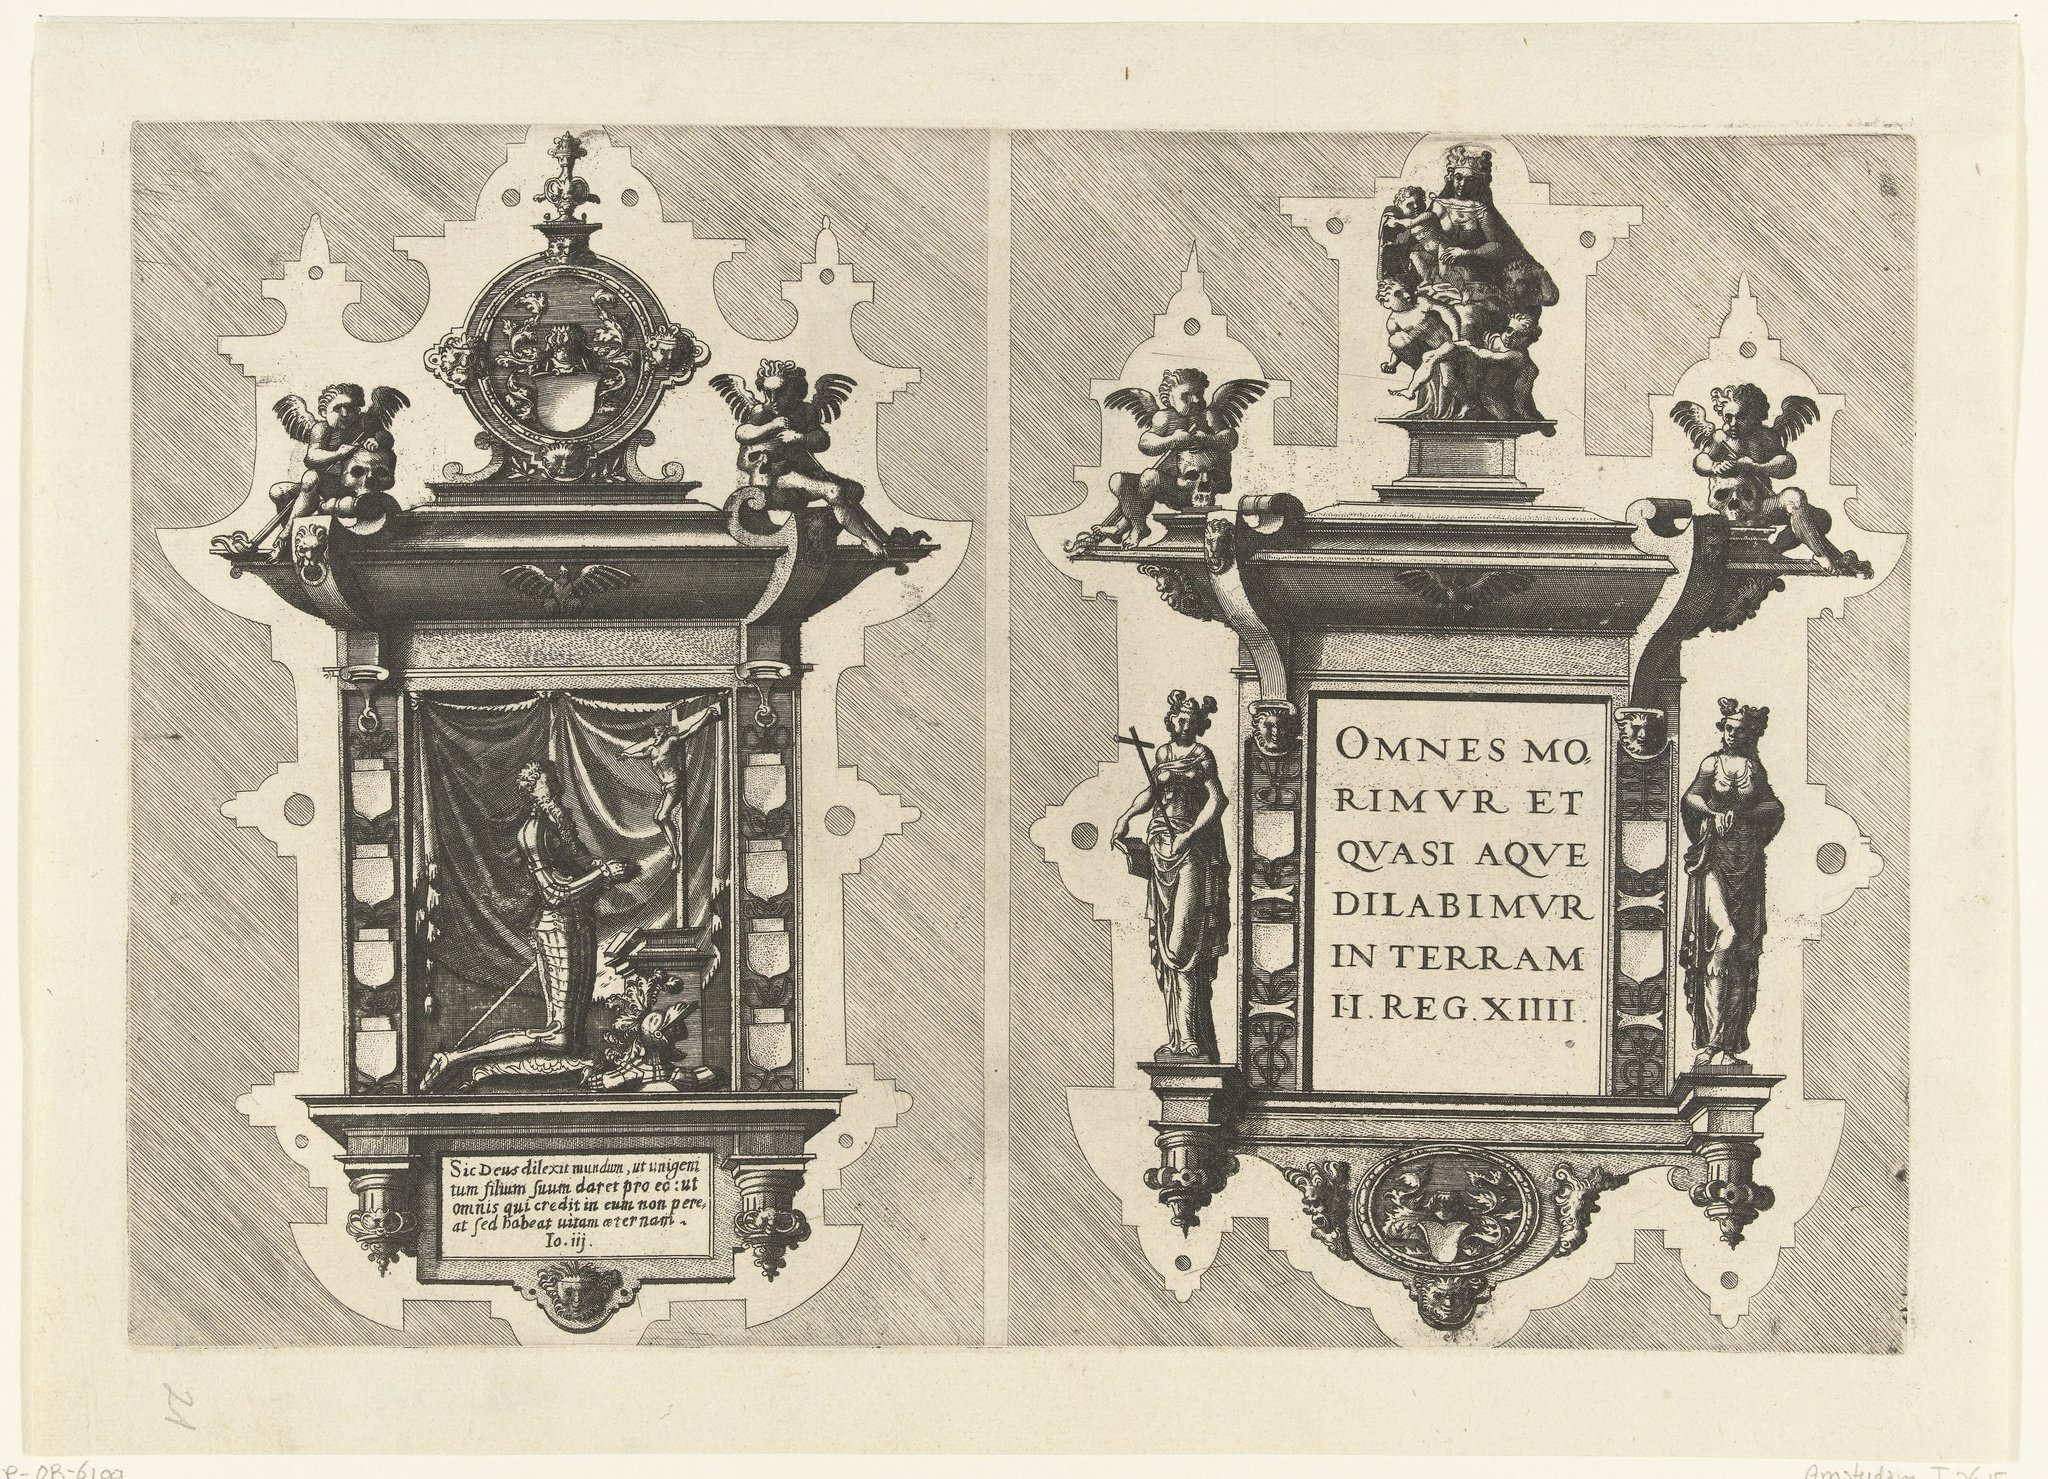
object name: print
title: Veelderleij niewe inventien van antijcksche sepultueren (...)Libro secundo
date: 1557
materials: paper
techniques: etching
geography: netherlands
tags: ornaments ~ art, the three theological virtues, epitaph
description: Twee epitafen. Links een hoofdgestel in sarcofaagvorm boven een relief met een voorstelling van een biddende ridder. Rechts een hoofdgestel in de vorm van sarcofaag boven een plaat met inscriptie, geflankeerd door Fides en Spes. Op de sarcofaag staat Caritas. No. 15 uit serie: titelblad, tekstblad en 14 bladen met grotesken met rolwerk, saters, guirlandes, trofeeën, dieren en fantasiewezens.